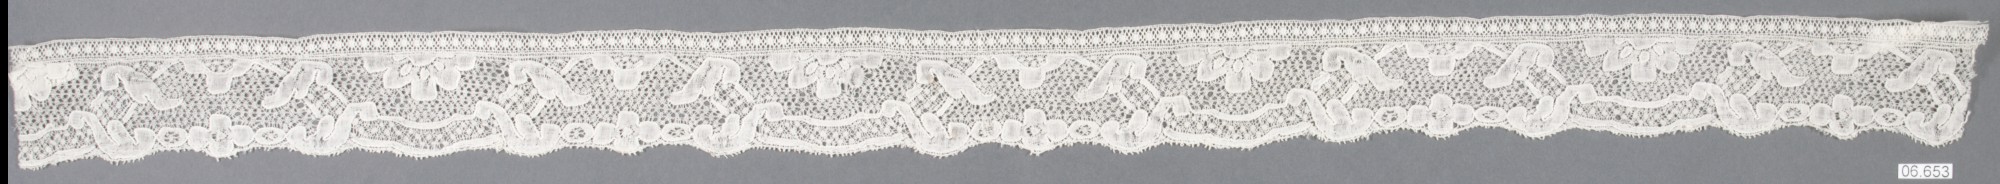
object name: piece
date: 1701-1800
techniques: lace